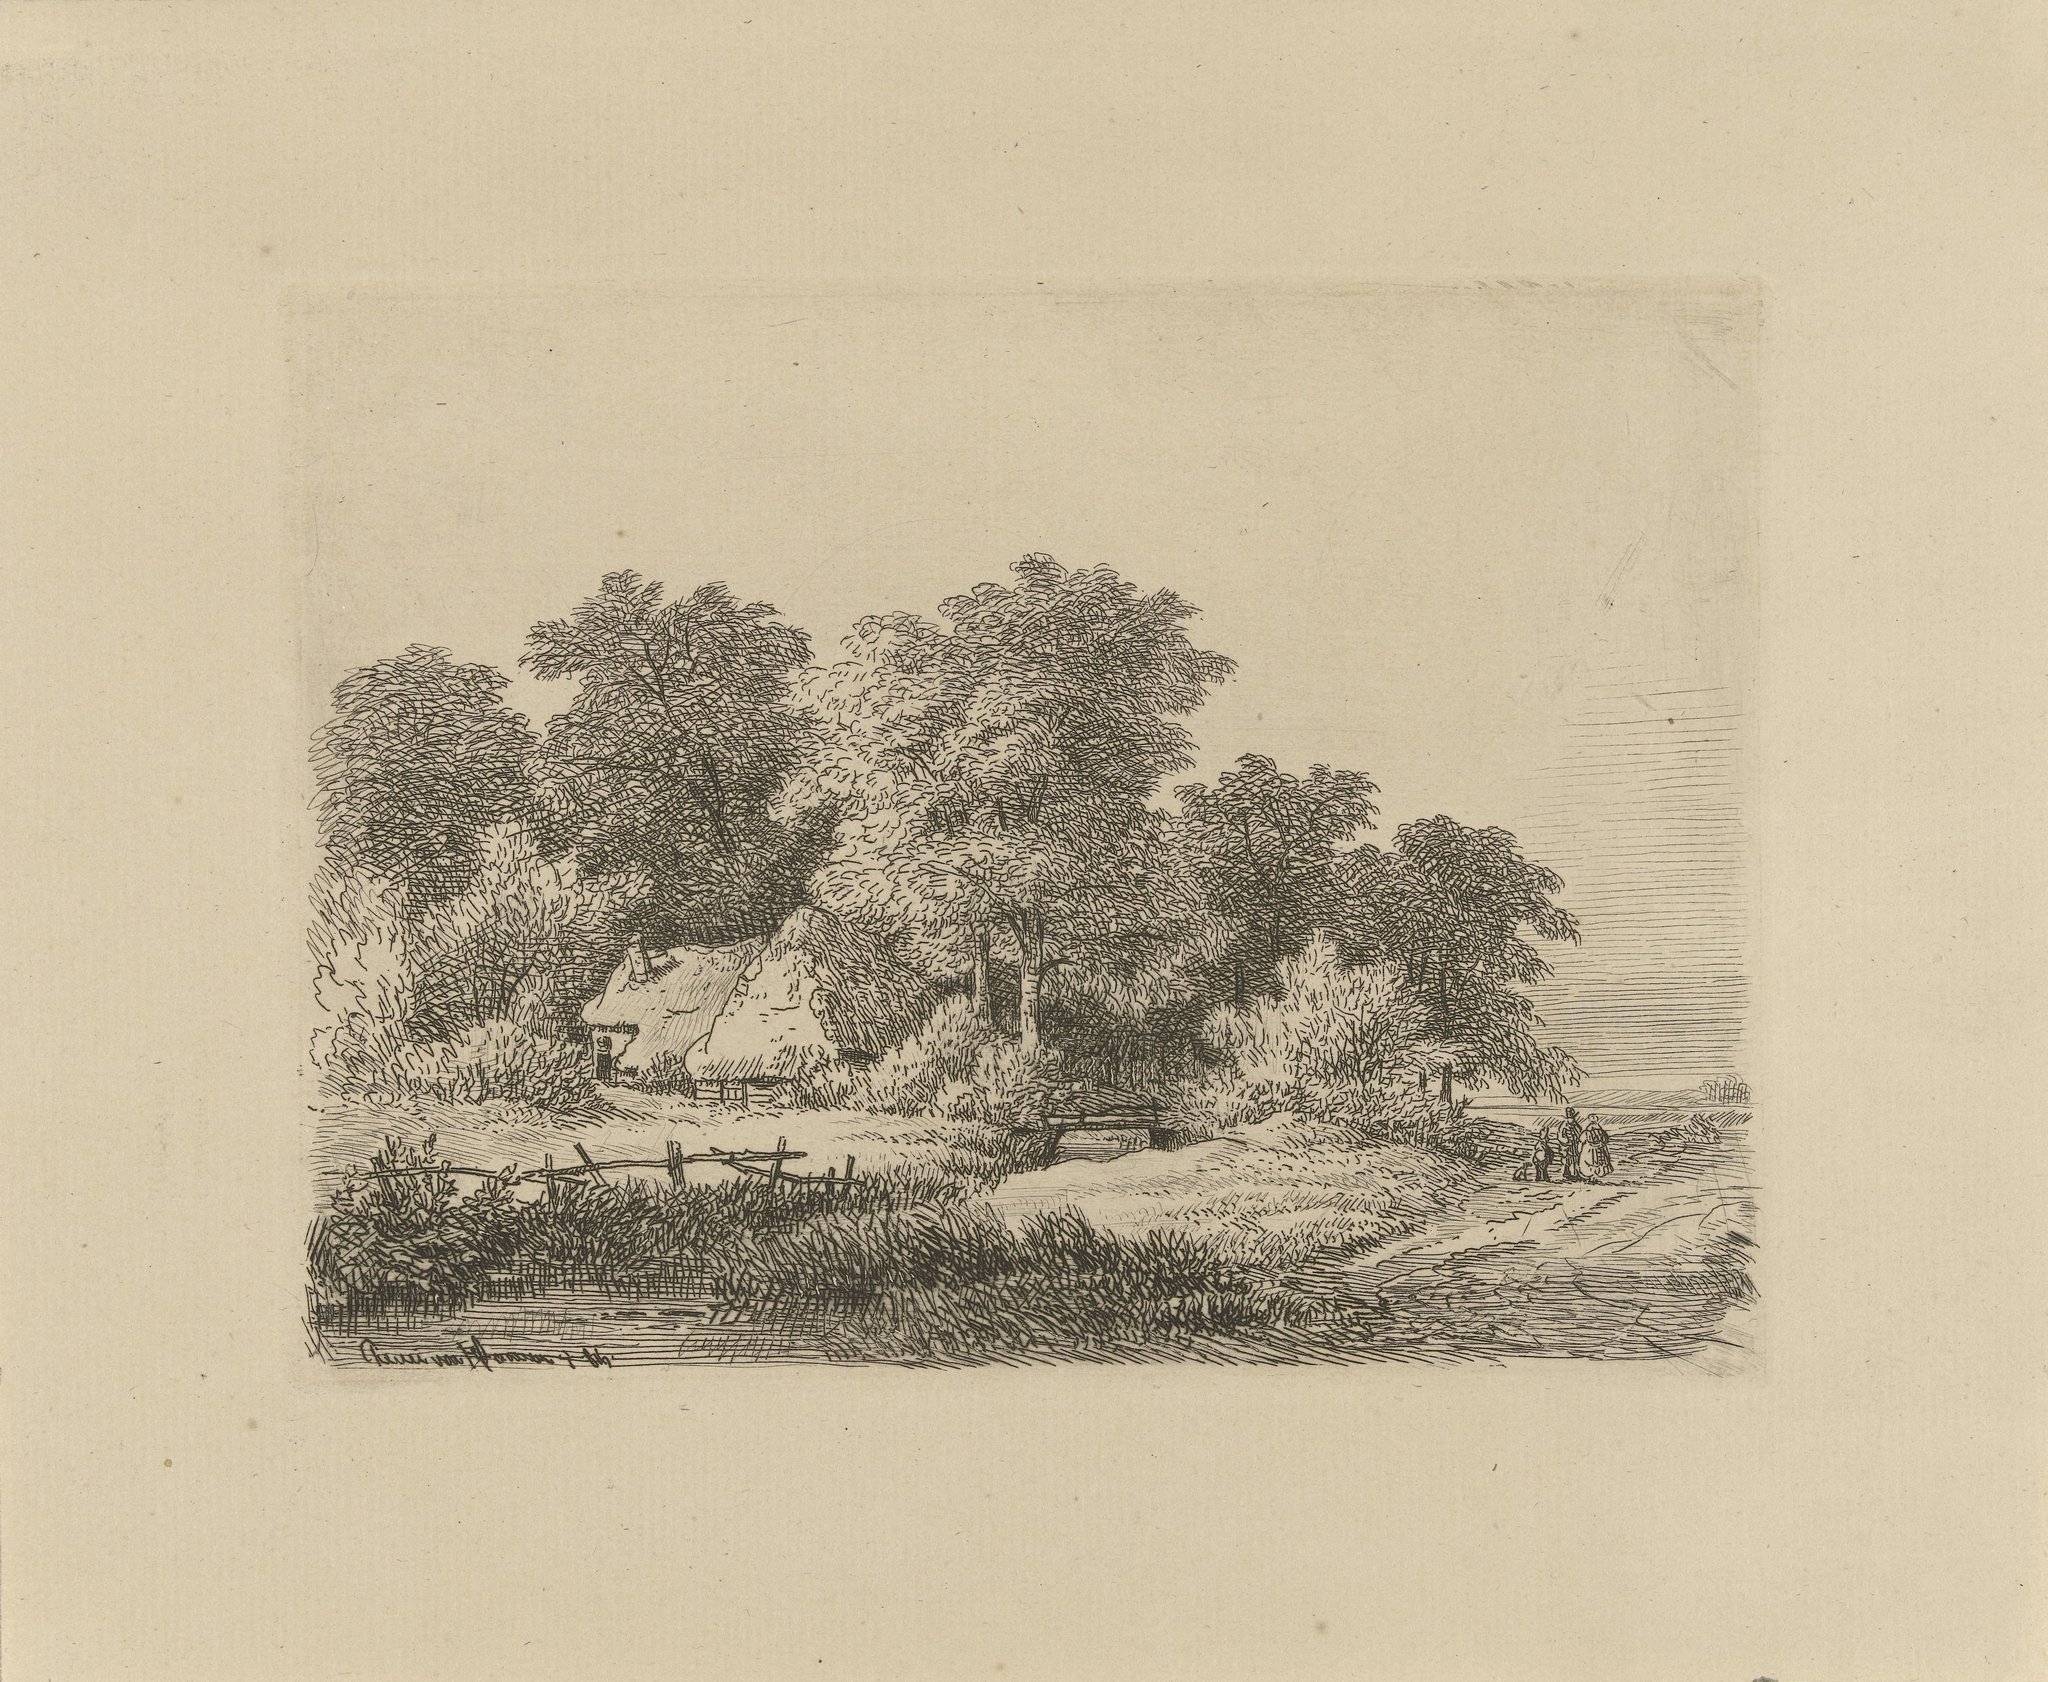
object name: print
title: Gezelschap op een landweg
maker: remigius adrianus haanen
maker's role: draughtsman, painter, print maker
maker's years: 1812-1894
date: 1849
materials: paper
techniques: etching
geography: austria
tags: farm or solitary house in landscape (+ city(-scape) with figures, staffage)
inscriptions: collector's mark: Lugt 2228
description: Drie figuren en een hond op een landweg bij een boerderij tussen bomen.